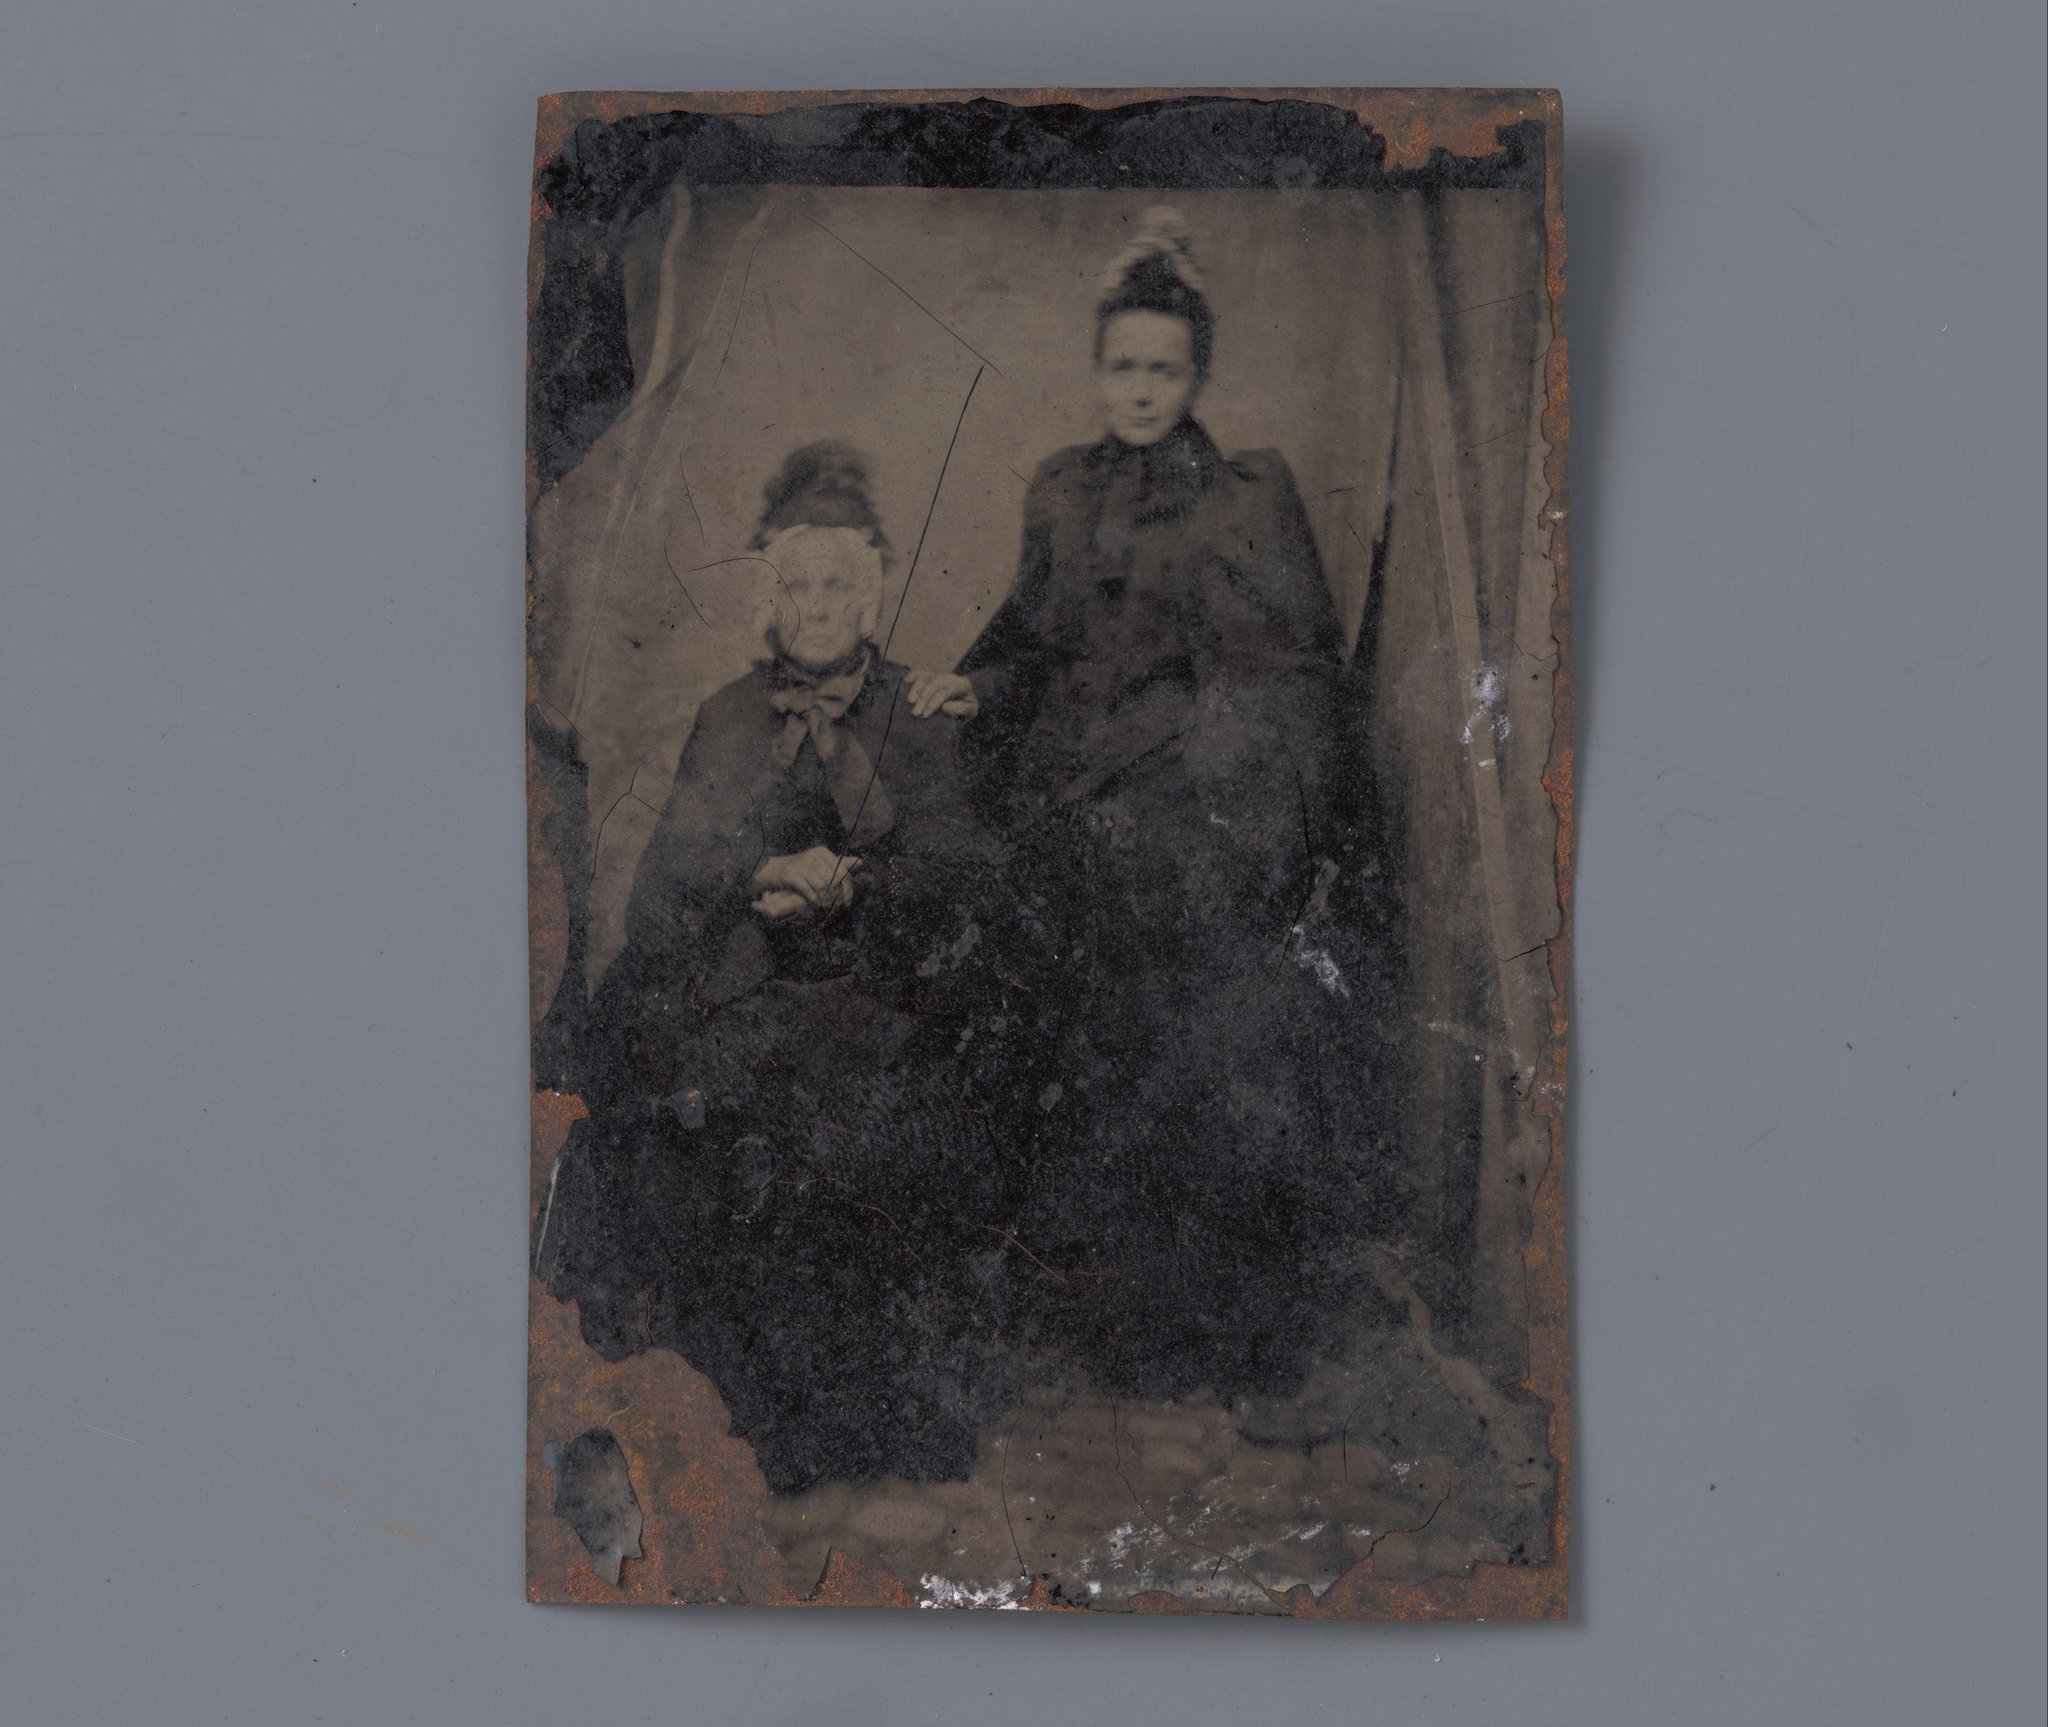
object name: photograph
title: Portret van twee onbekende vrouwen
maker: Anonymous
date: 1855-1900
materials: iron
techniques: ferrotyping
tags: historical persons - bb - woman, head-gear: hat, adult woman (+ two persons)